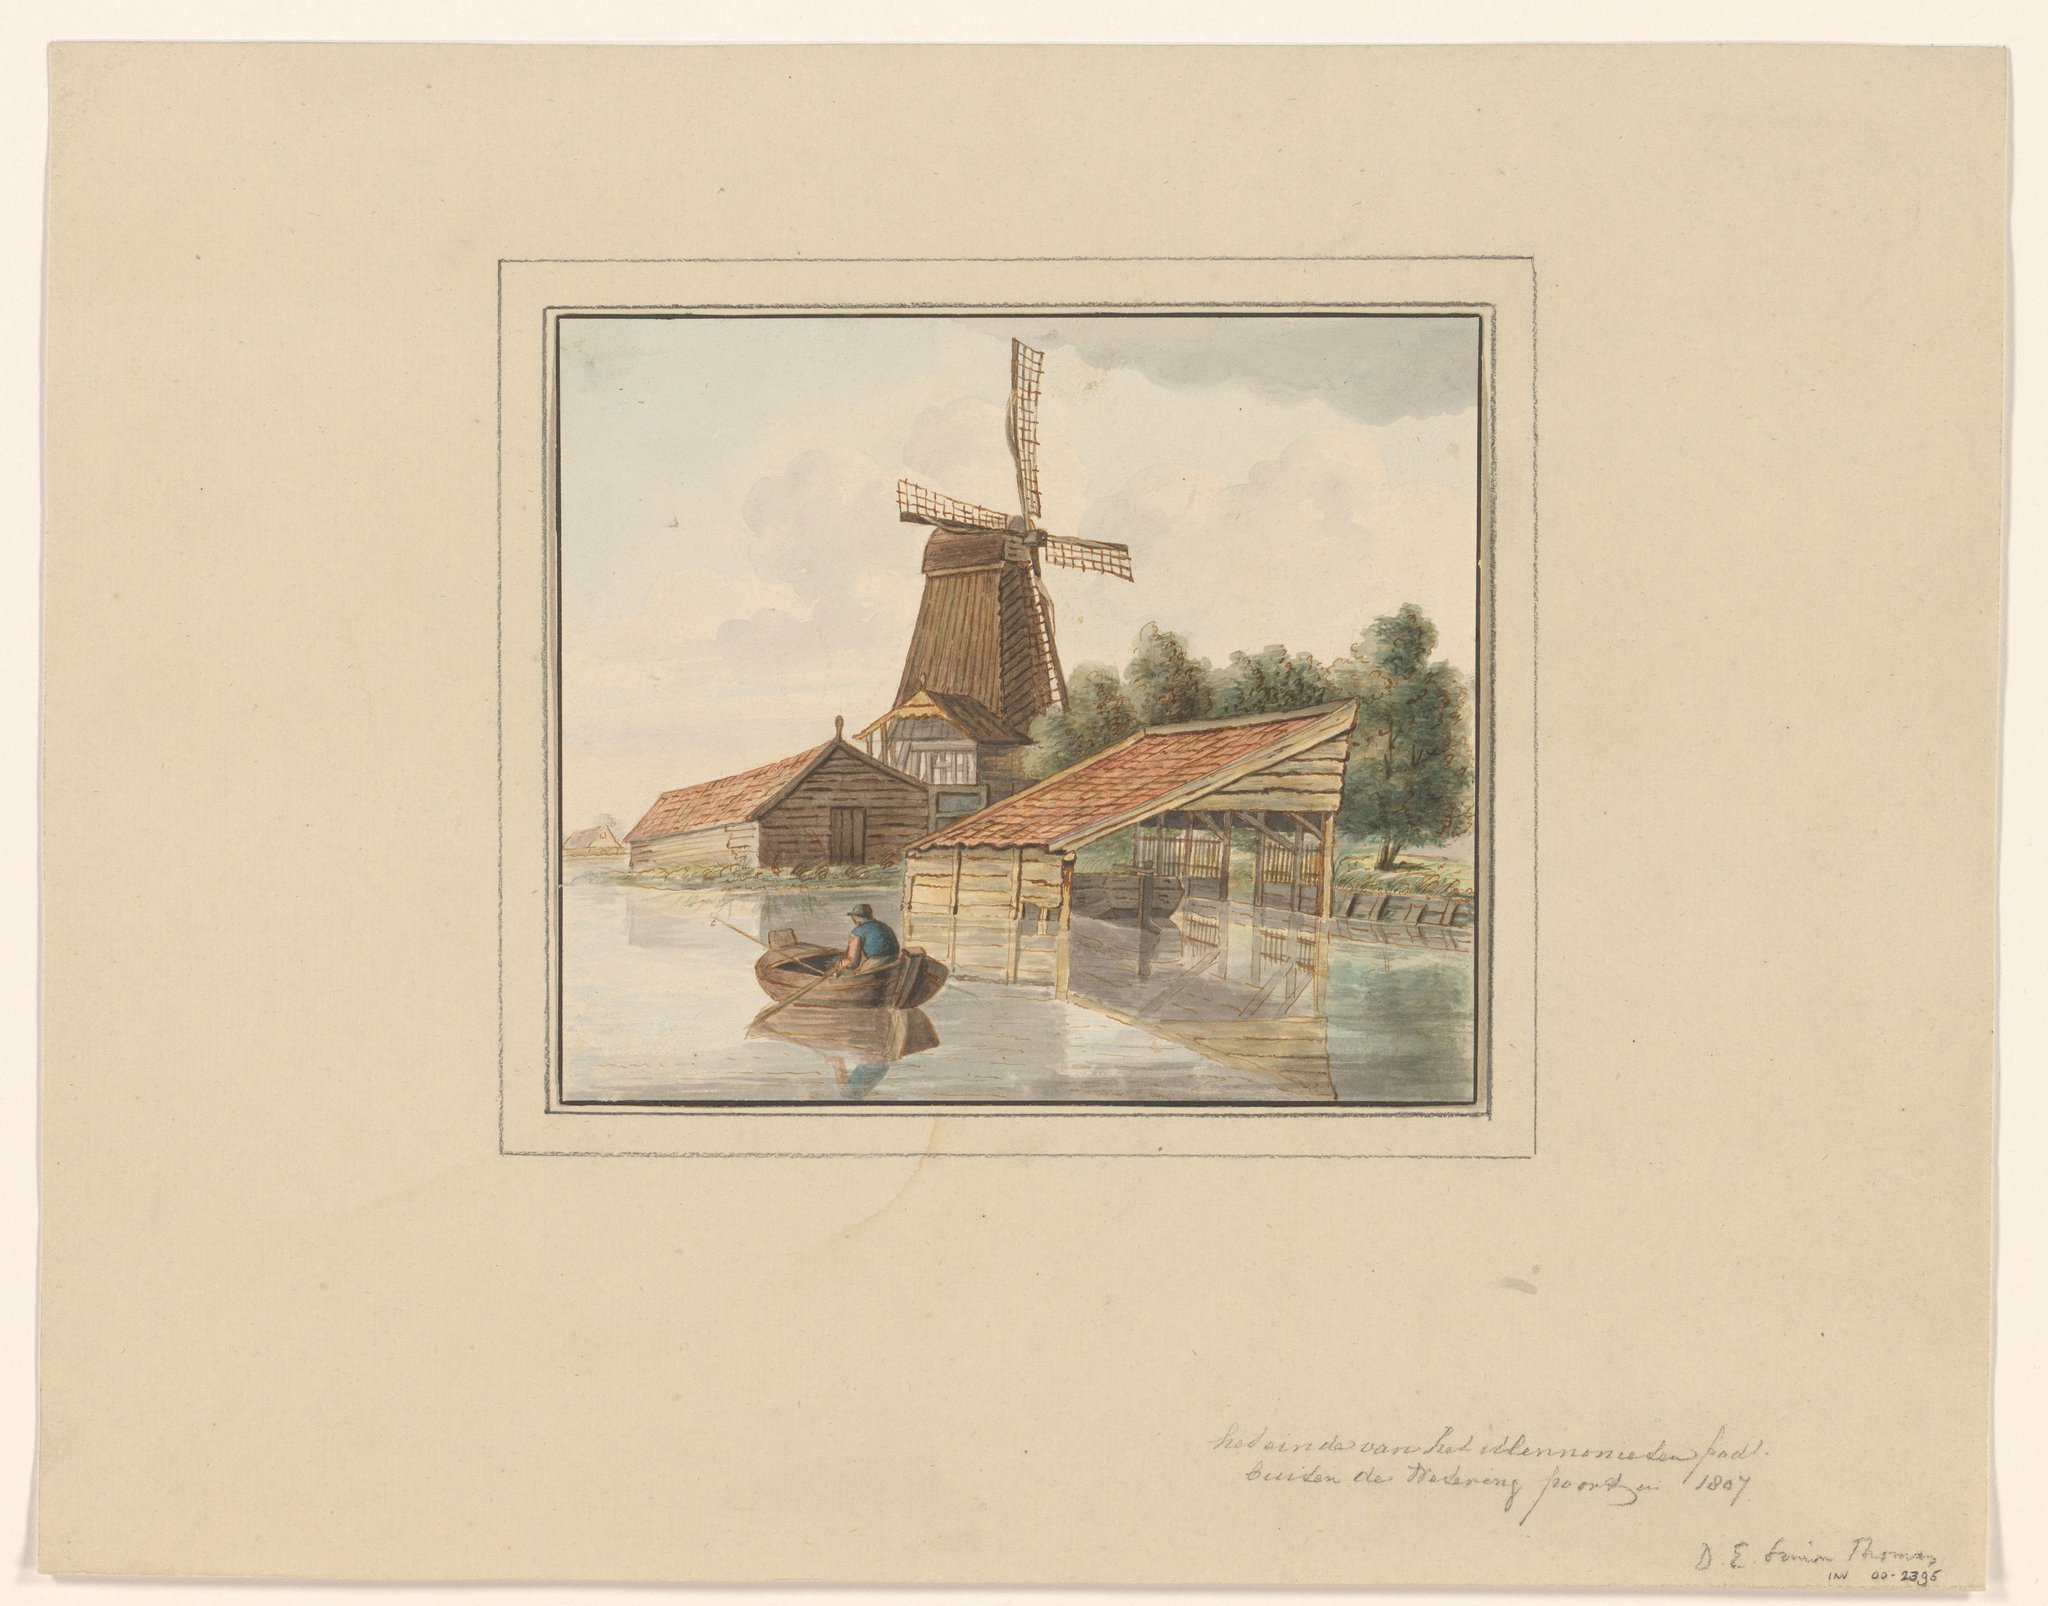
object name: drawing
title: Houtzaagmolen 't Aalsmeerderwapen aan de Mennonietensloot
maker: d.e. simon thomas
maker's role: draughtsman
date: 1807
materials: ink, paper, pencil, watercolor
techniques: brush, pen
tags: saw-mill (works)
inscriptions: inscription: ‘ten eynde van het Menoniete Pad. by de Weeterings Poort./ G'offreerd aan mijn Zeer Waarde Vriend den Heer A : Brondgeest./ door Z: Ed: vrind D: E: Simon Thomas./ 7 obr. 1807’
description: De houtzaagmolen werd in 1834 afgebroken.